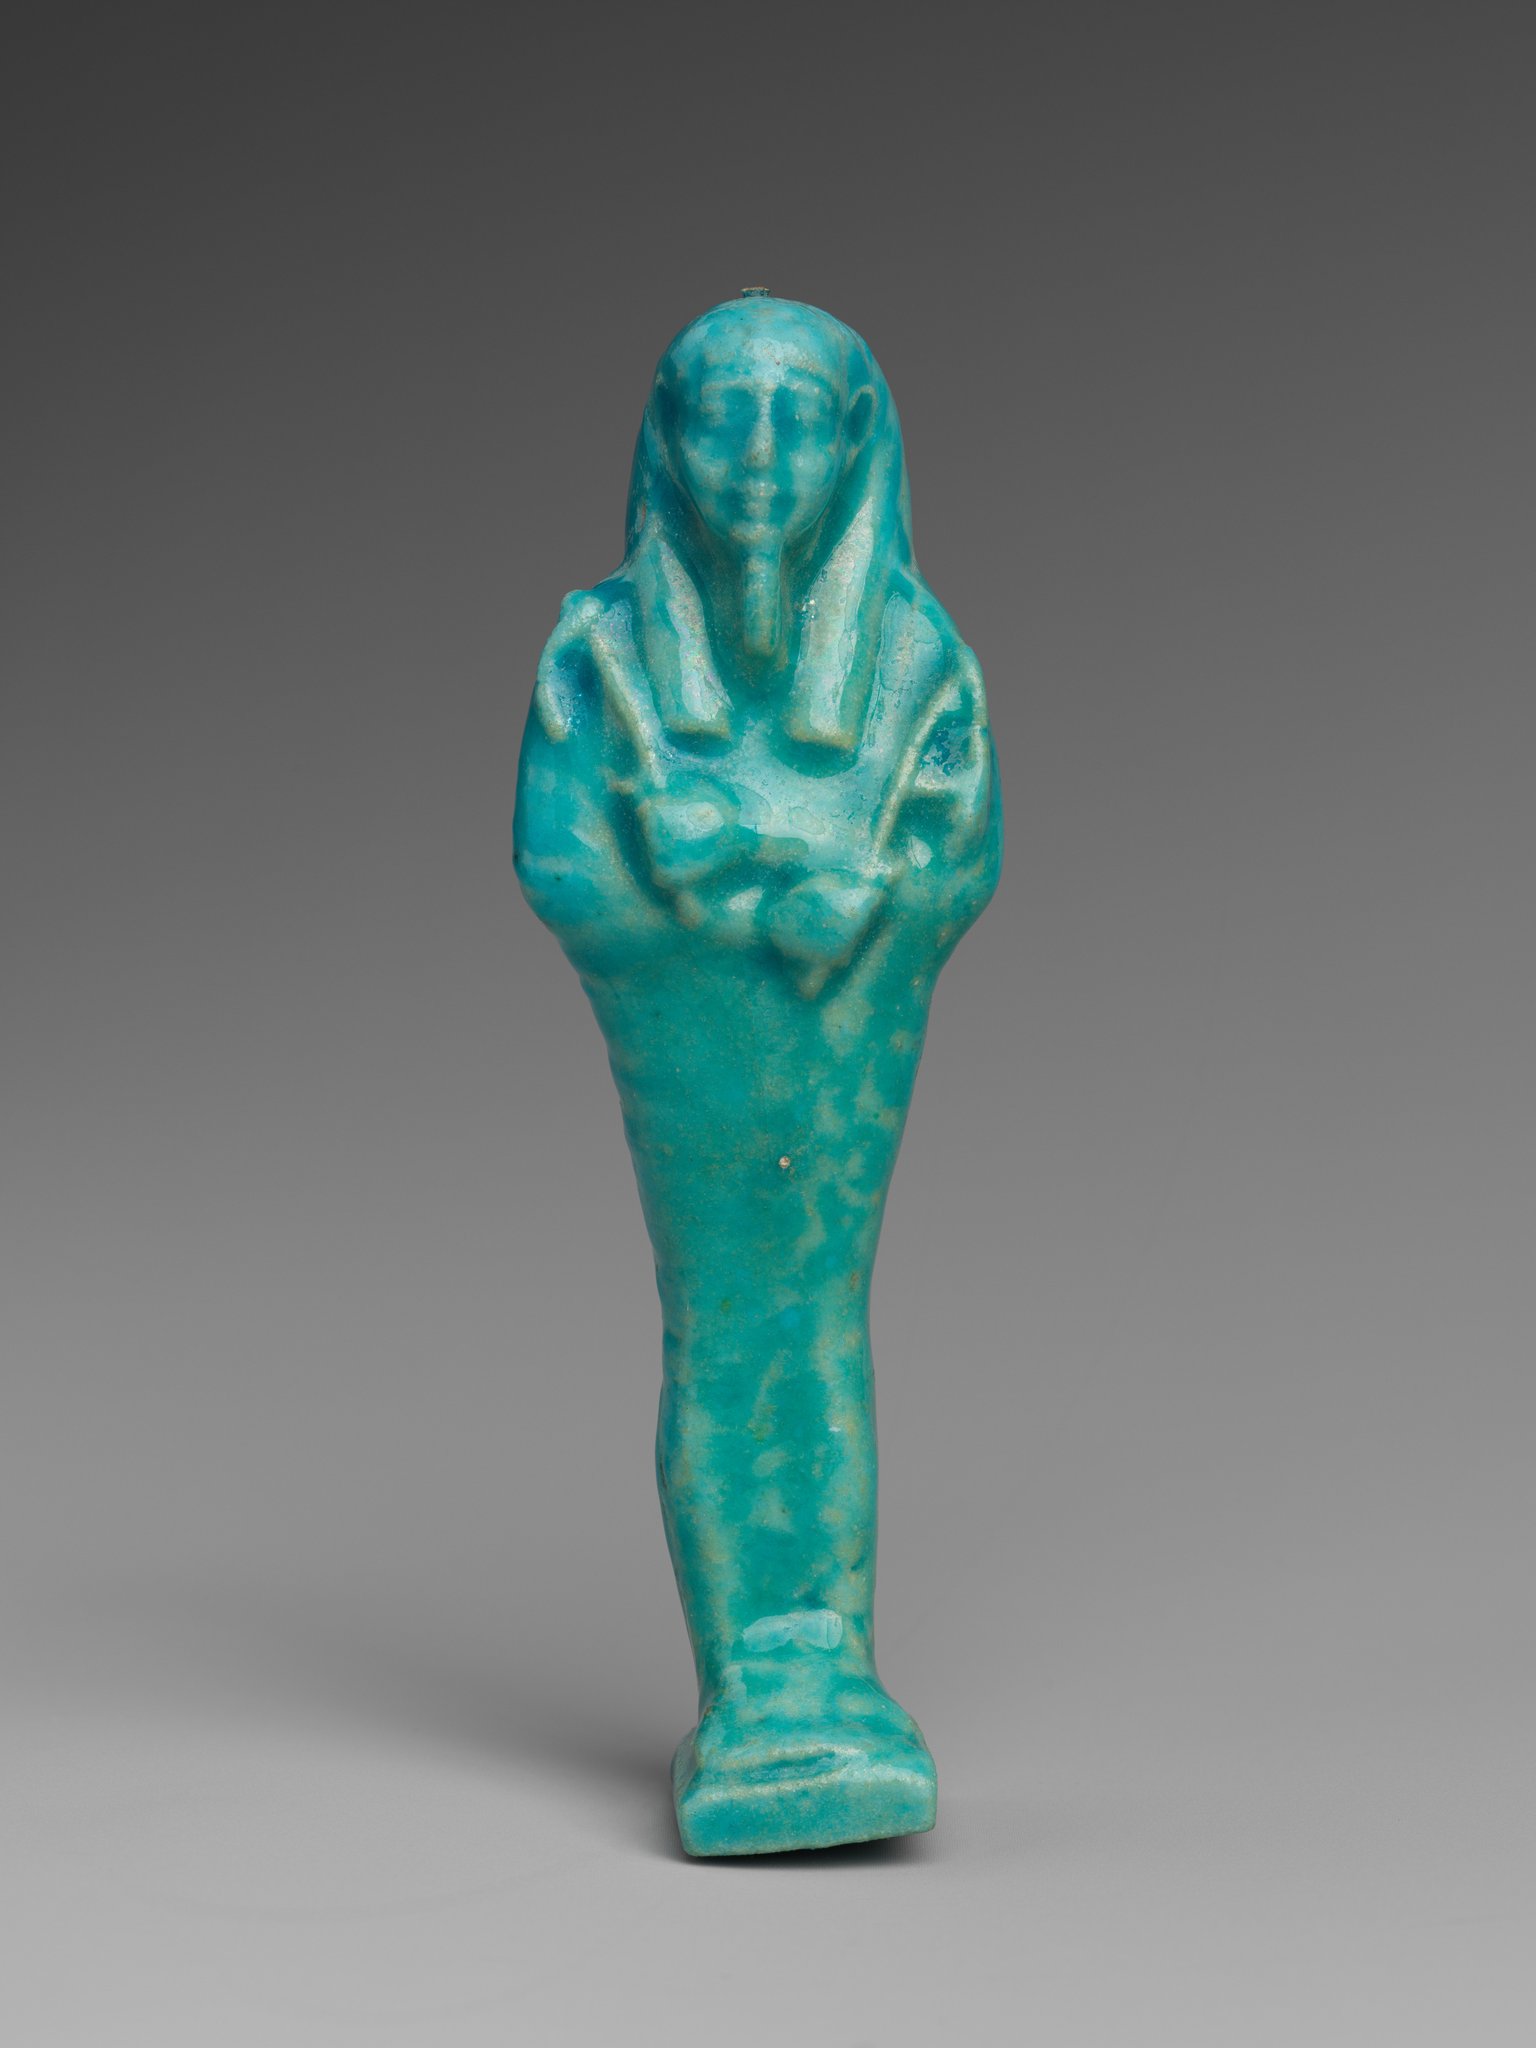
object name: shabti, petosiris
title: Shabti of Petosiris, son of Djedhor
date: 360-300 BCE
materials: faience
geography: egypt